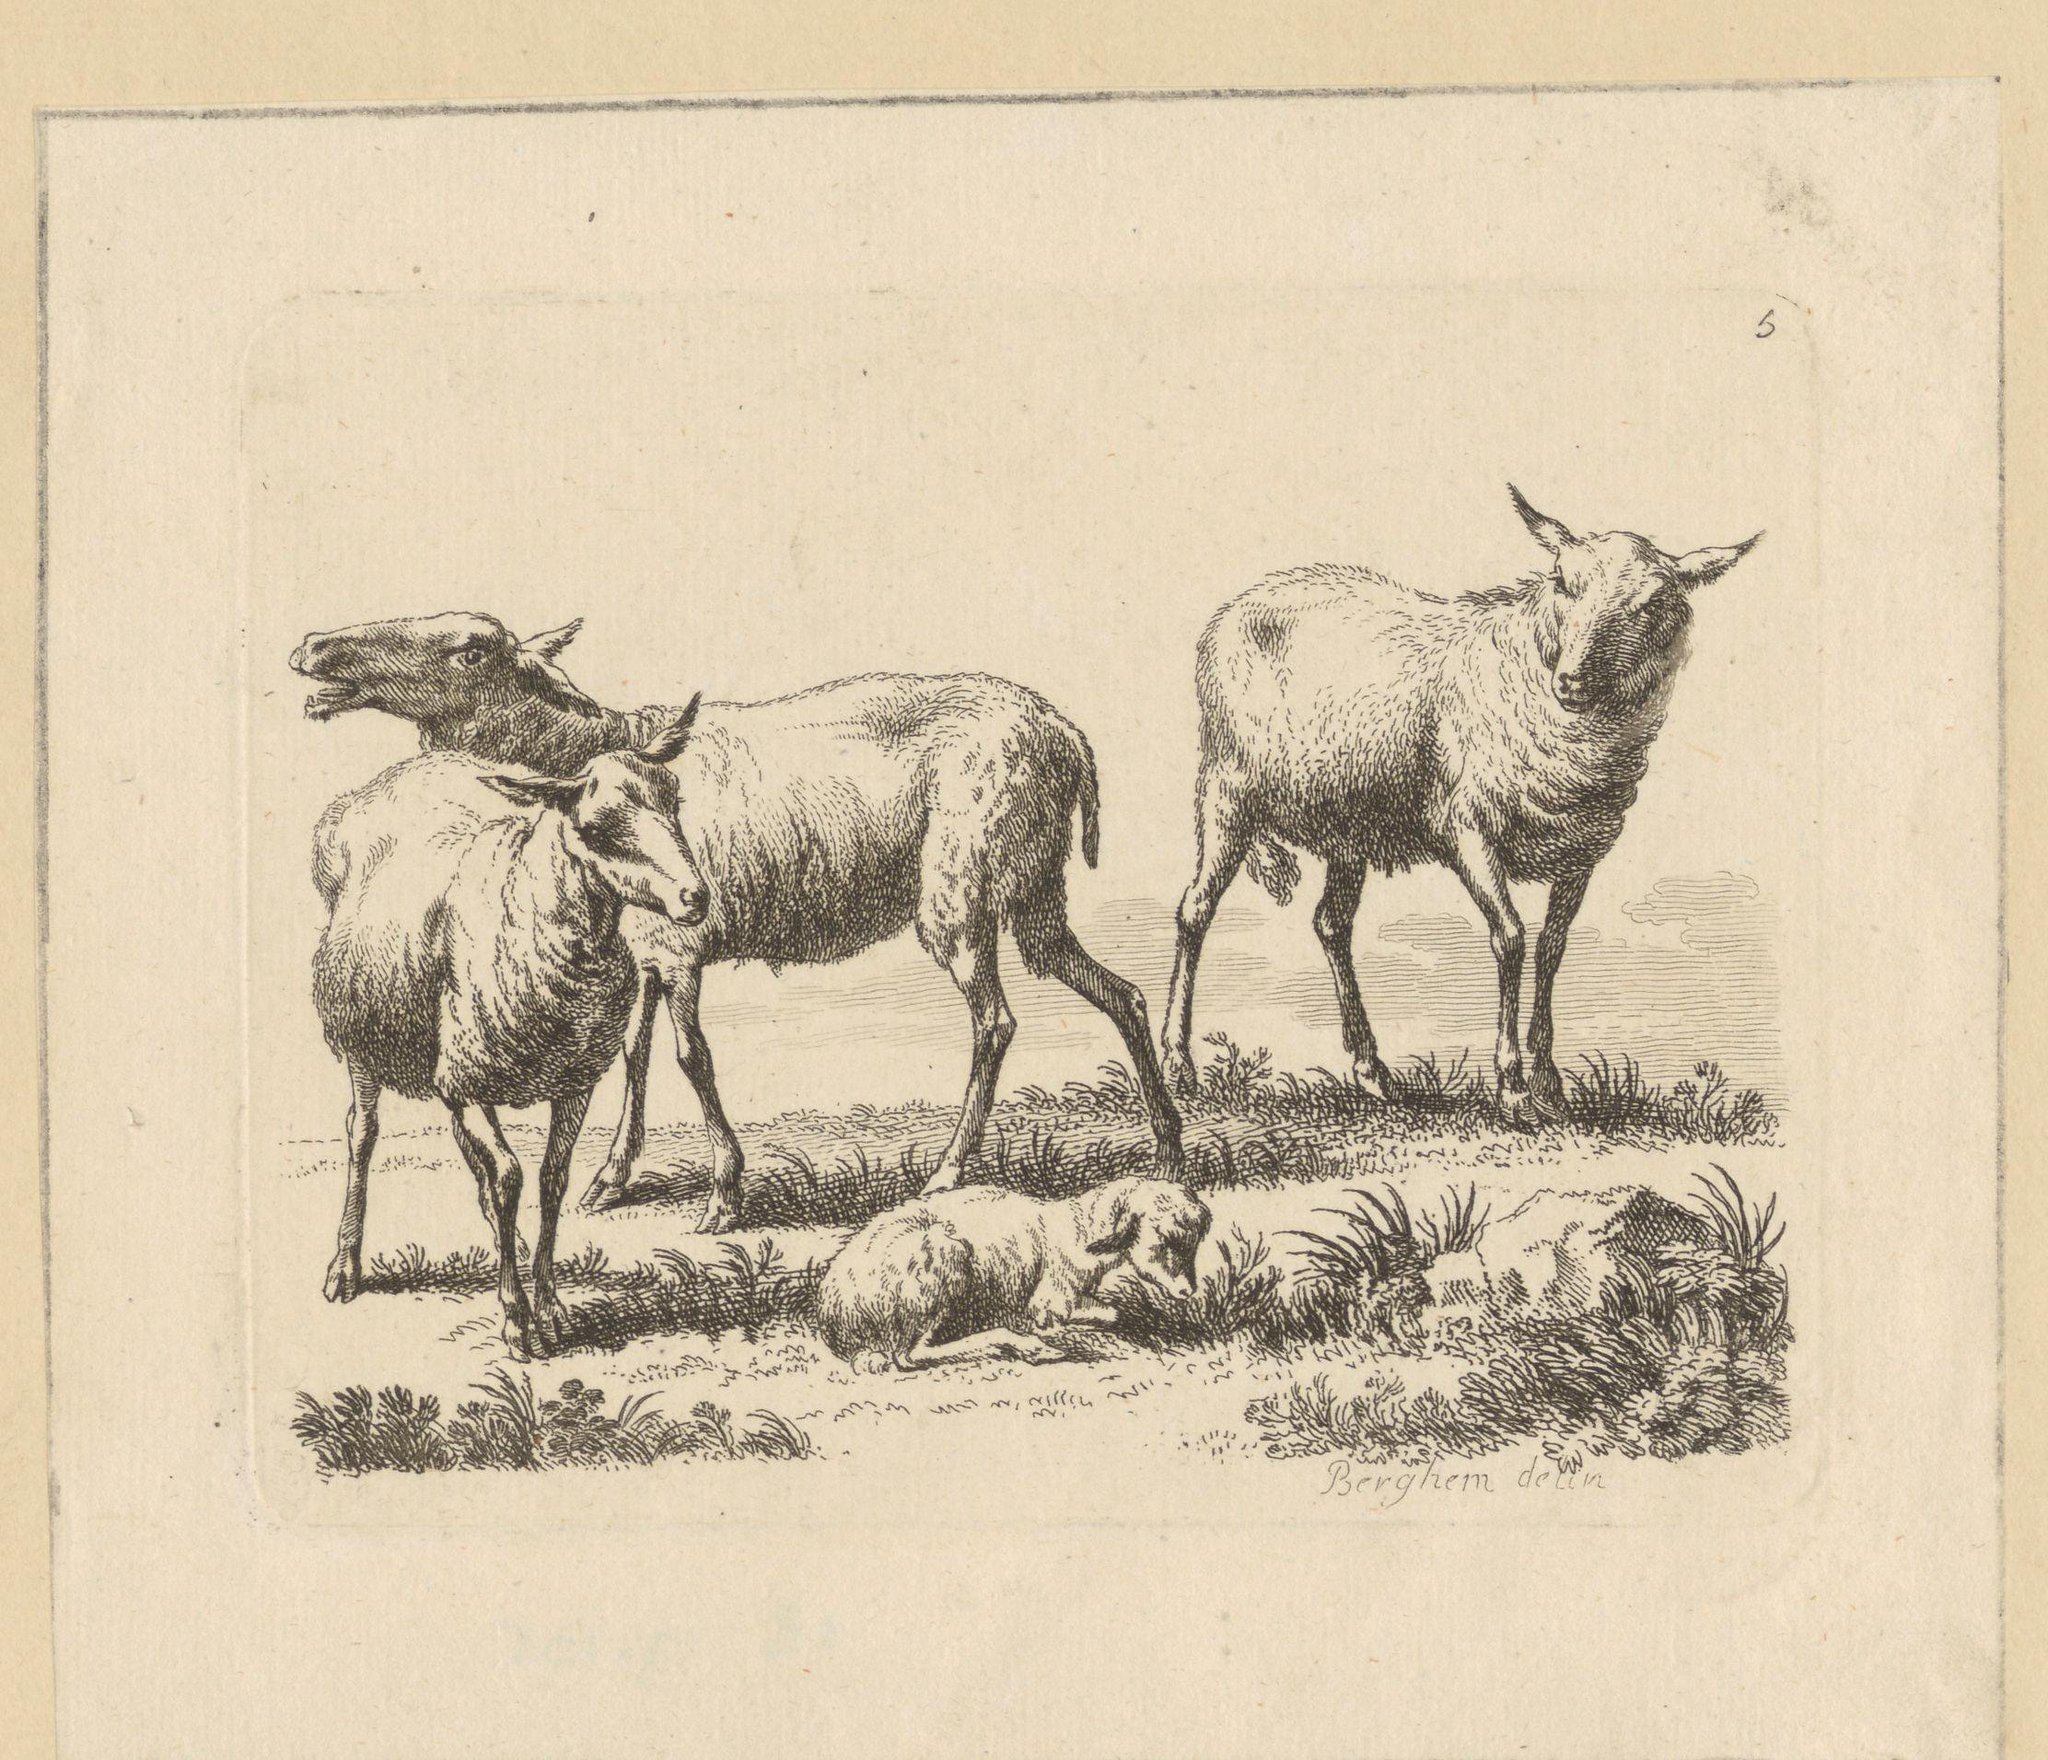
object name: print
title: Geiten en schapen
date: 1719-1780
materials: paper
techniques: etching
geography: london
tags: lamb, sheep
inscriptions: collector's mark: Lugt 240